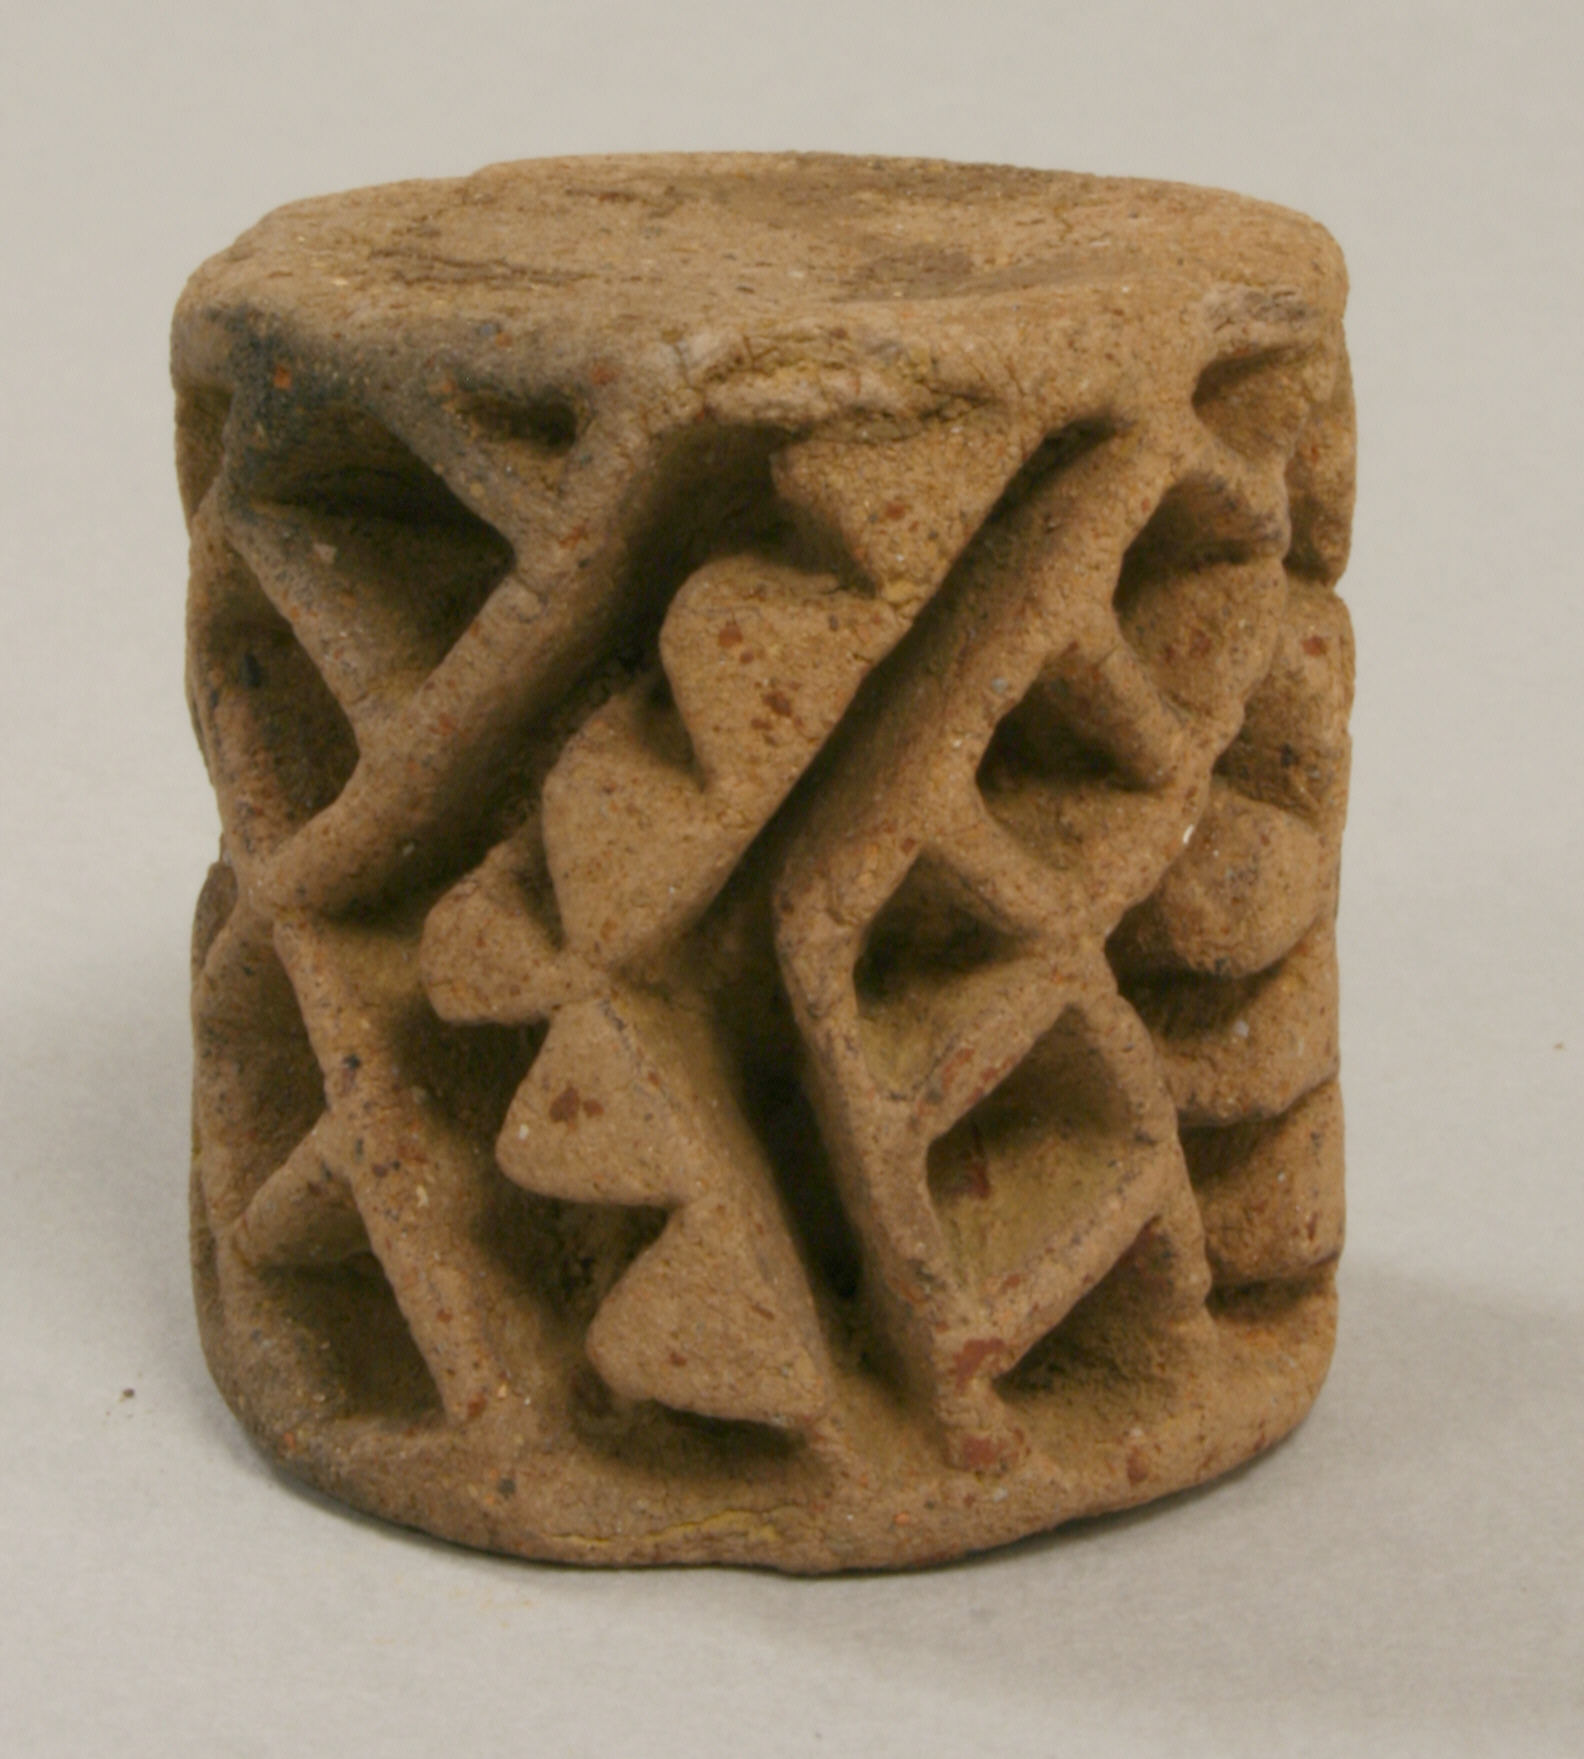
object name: stamp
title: Cylinder Seal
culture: atlantic watershed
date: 401-600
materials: ceramic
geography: costa rica